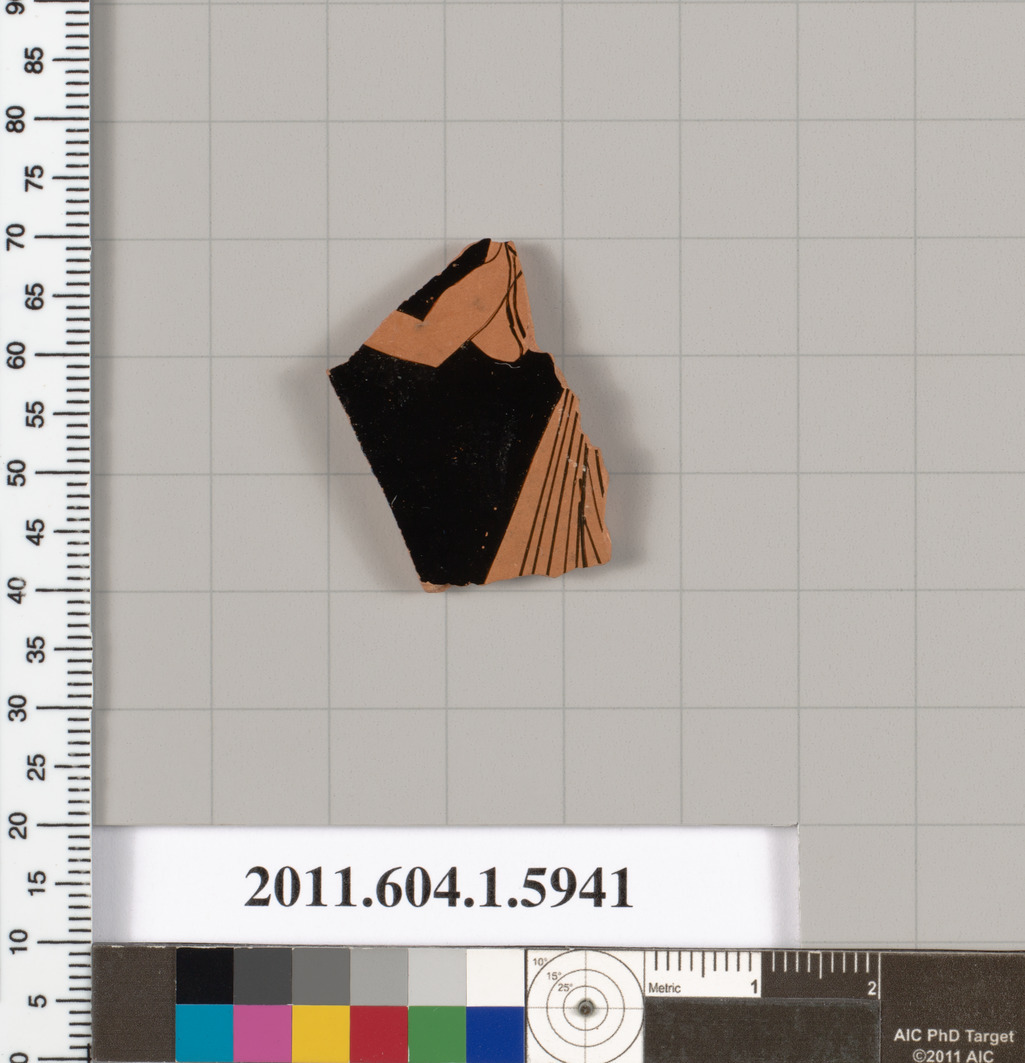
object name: kylix fragment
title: Terracotta fragment of a kylix (drinking cup)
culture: greek, attic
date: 433-567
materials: terracotta